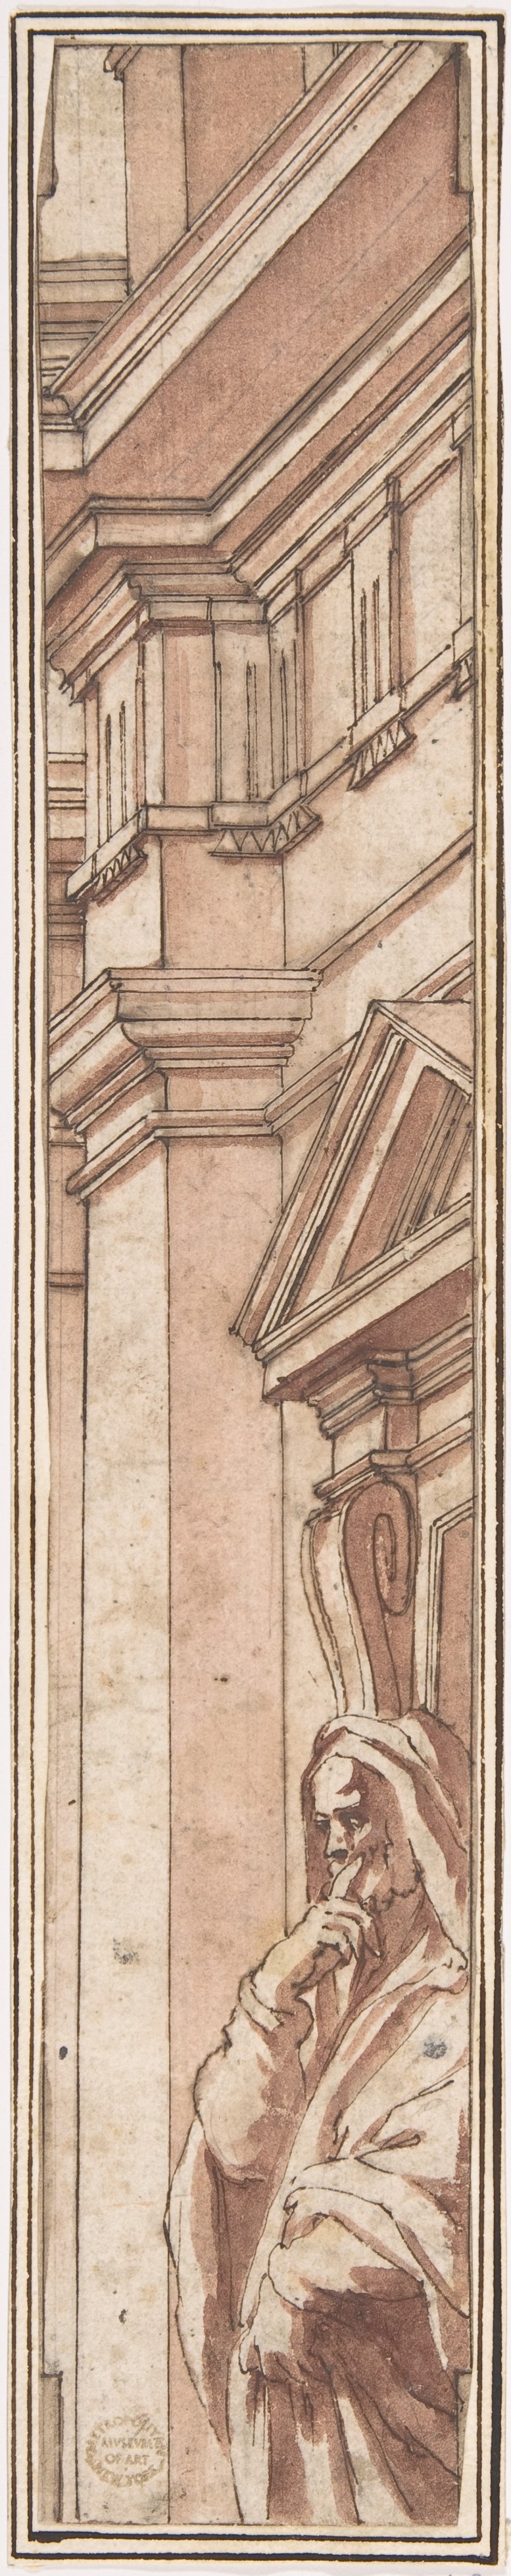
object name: drawing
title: Façade (for Stage Setting)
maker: anonymous, italian, 16th century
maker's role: artist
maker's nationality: italian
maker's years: 1550-1600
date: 1501-1600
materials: ink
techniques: pen, wash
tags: architecture